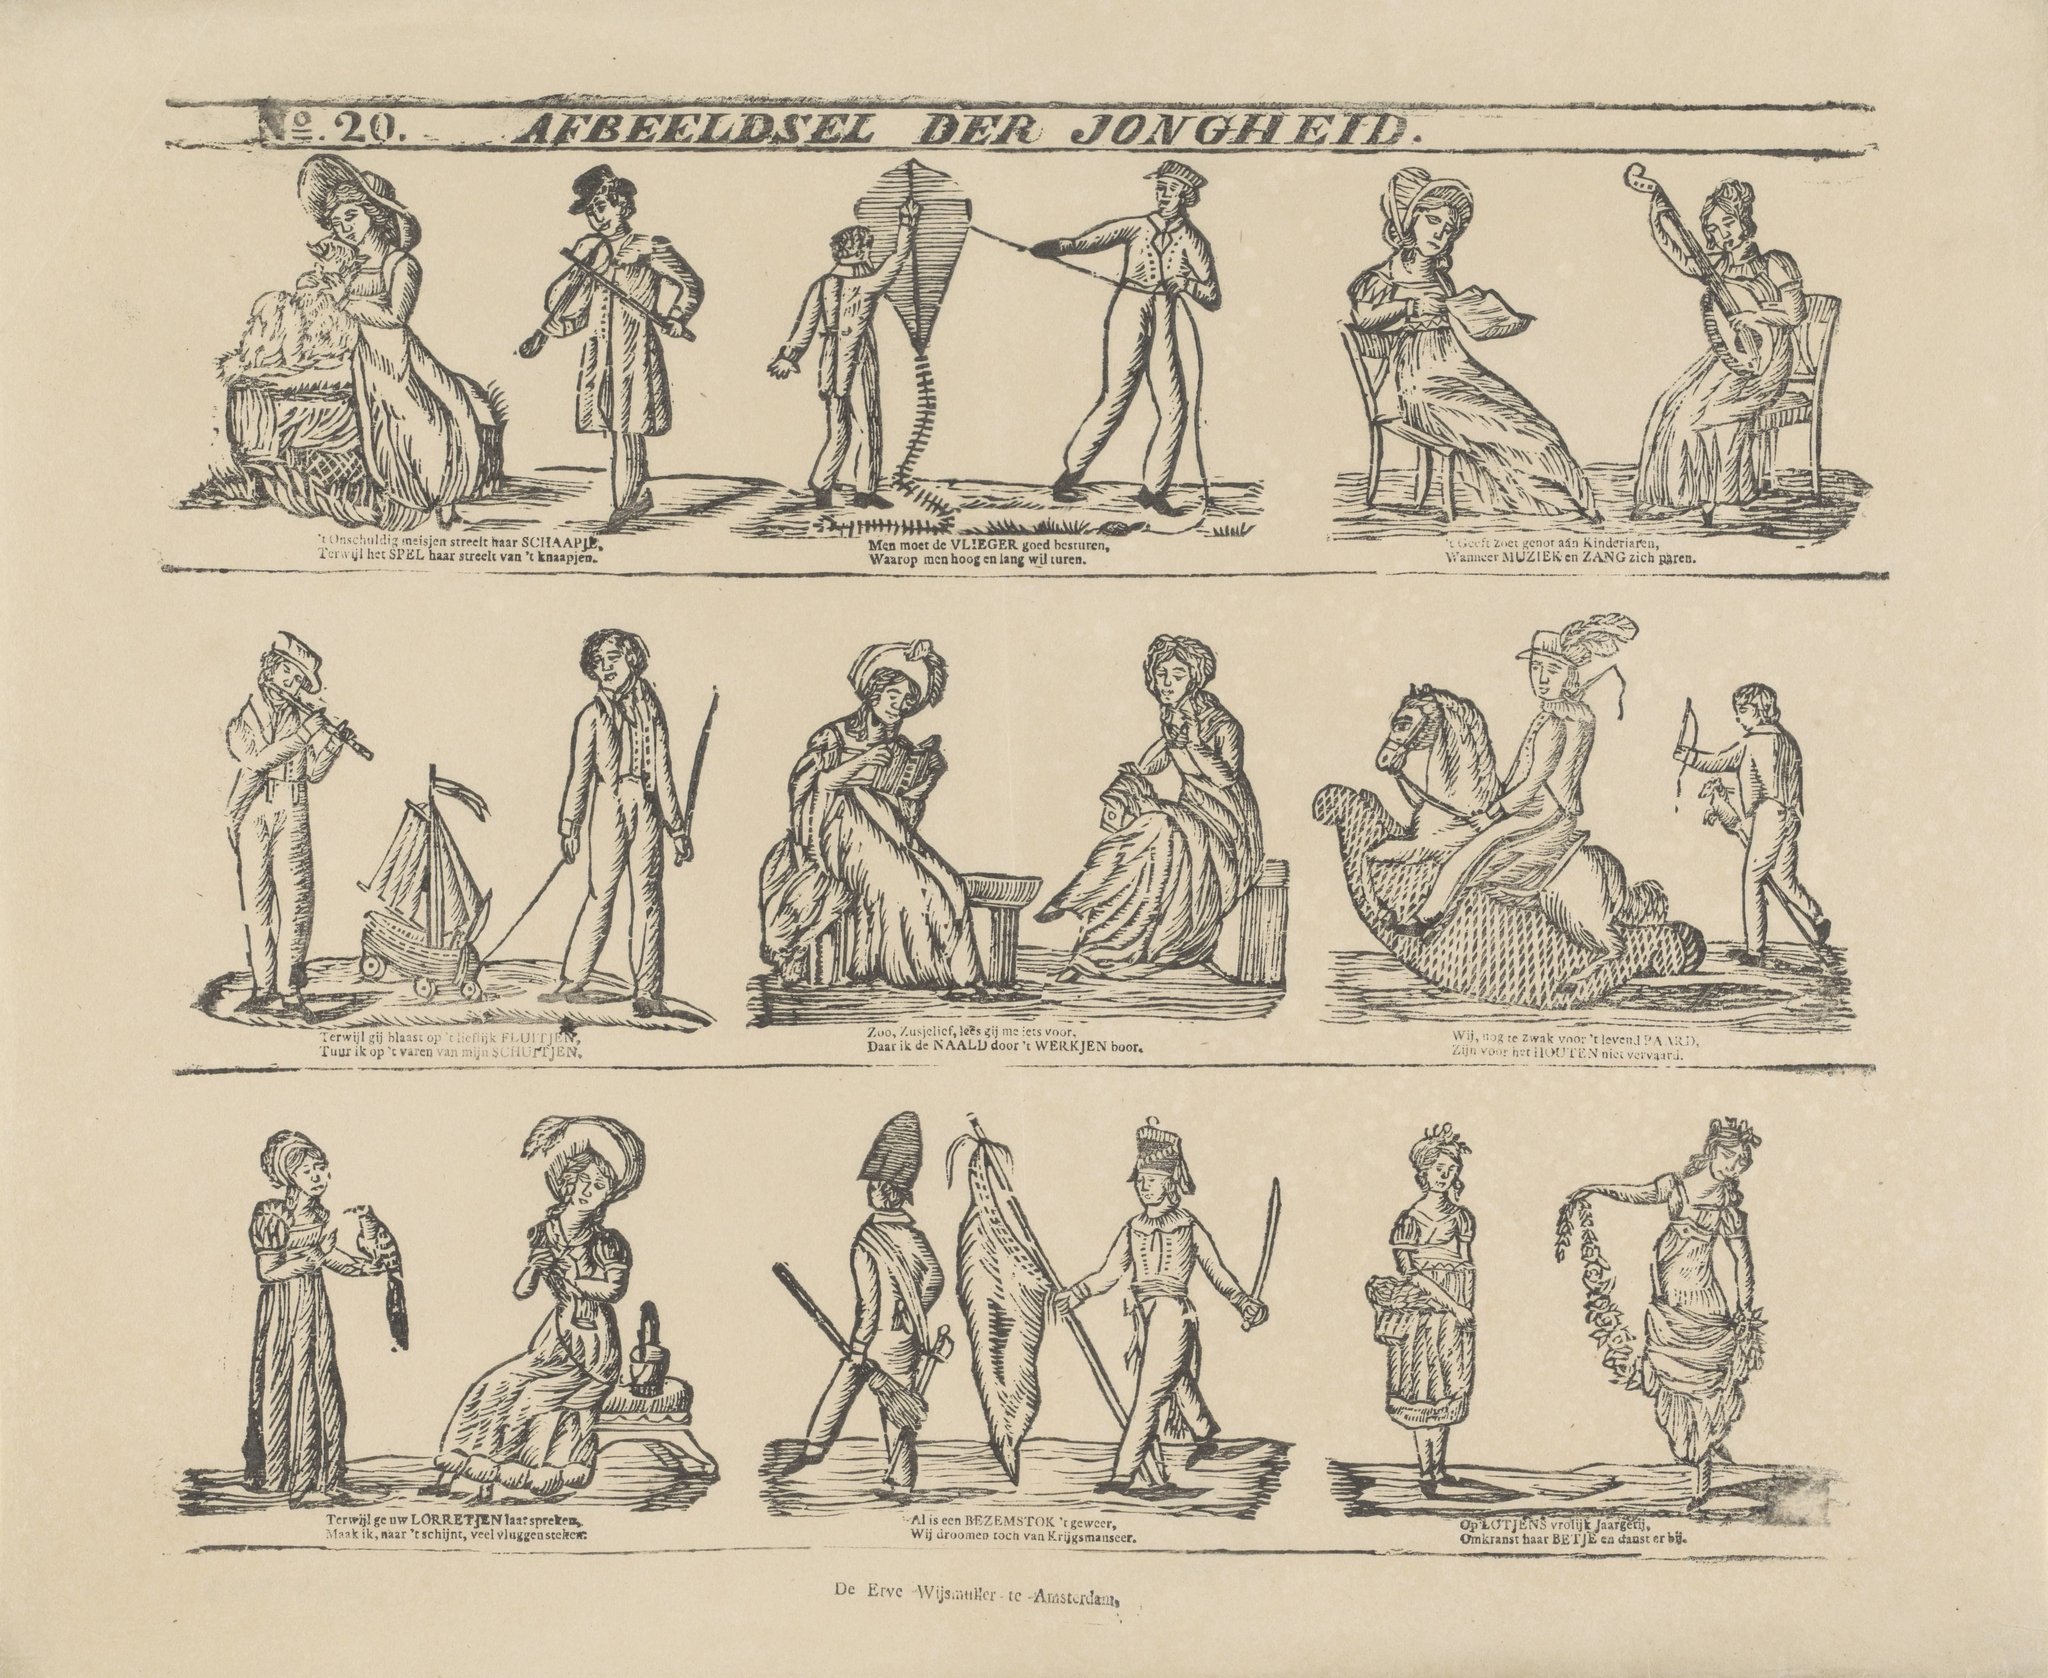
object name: popular print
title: Afbeeldsel der jongheid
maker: Anonymous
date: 1828-1913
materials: paper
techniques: woodcut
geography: amsterdam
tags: children's games and plays, (flying a) kite, rocking-horse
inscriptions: collector's mark: Lugt 2760, collector's mark: Lugt 2228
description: Blad met 3 horizontale rijen met voorstellingen van kinderspelen en bezigheden, zoals vliegeren, zingen, lezen en dansen. Onder elke afbeelding een odnerschrift. Genummerd linksboven: no. 20.